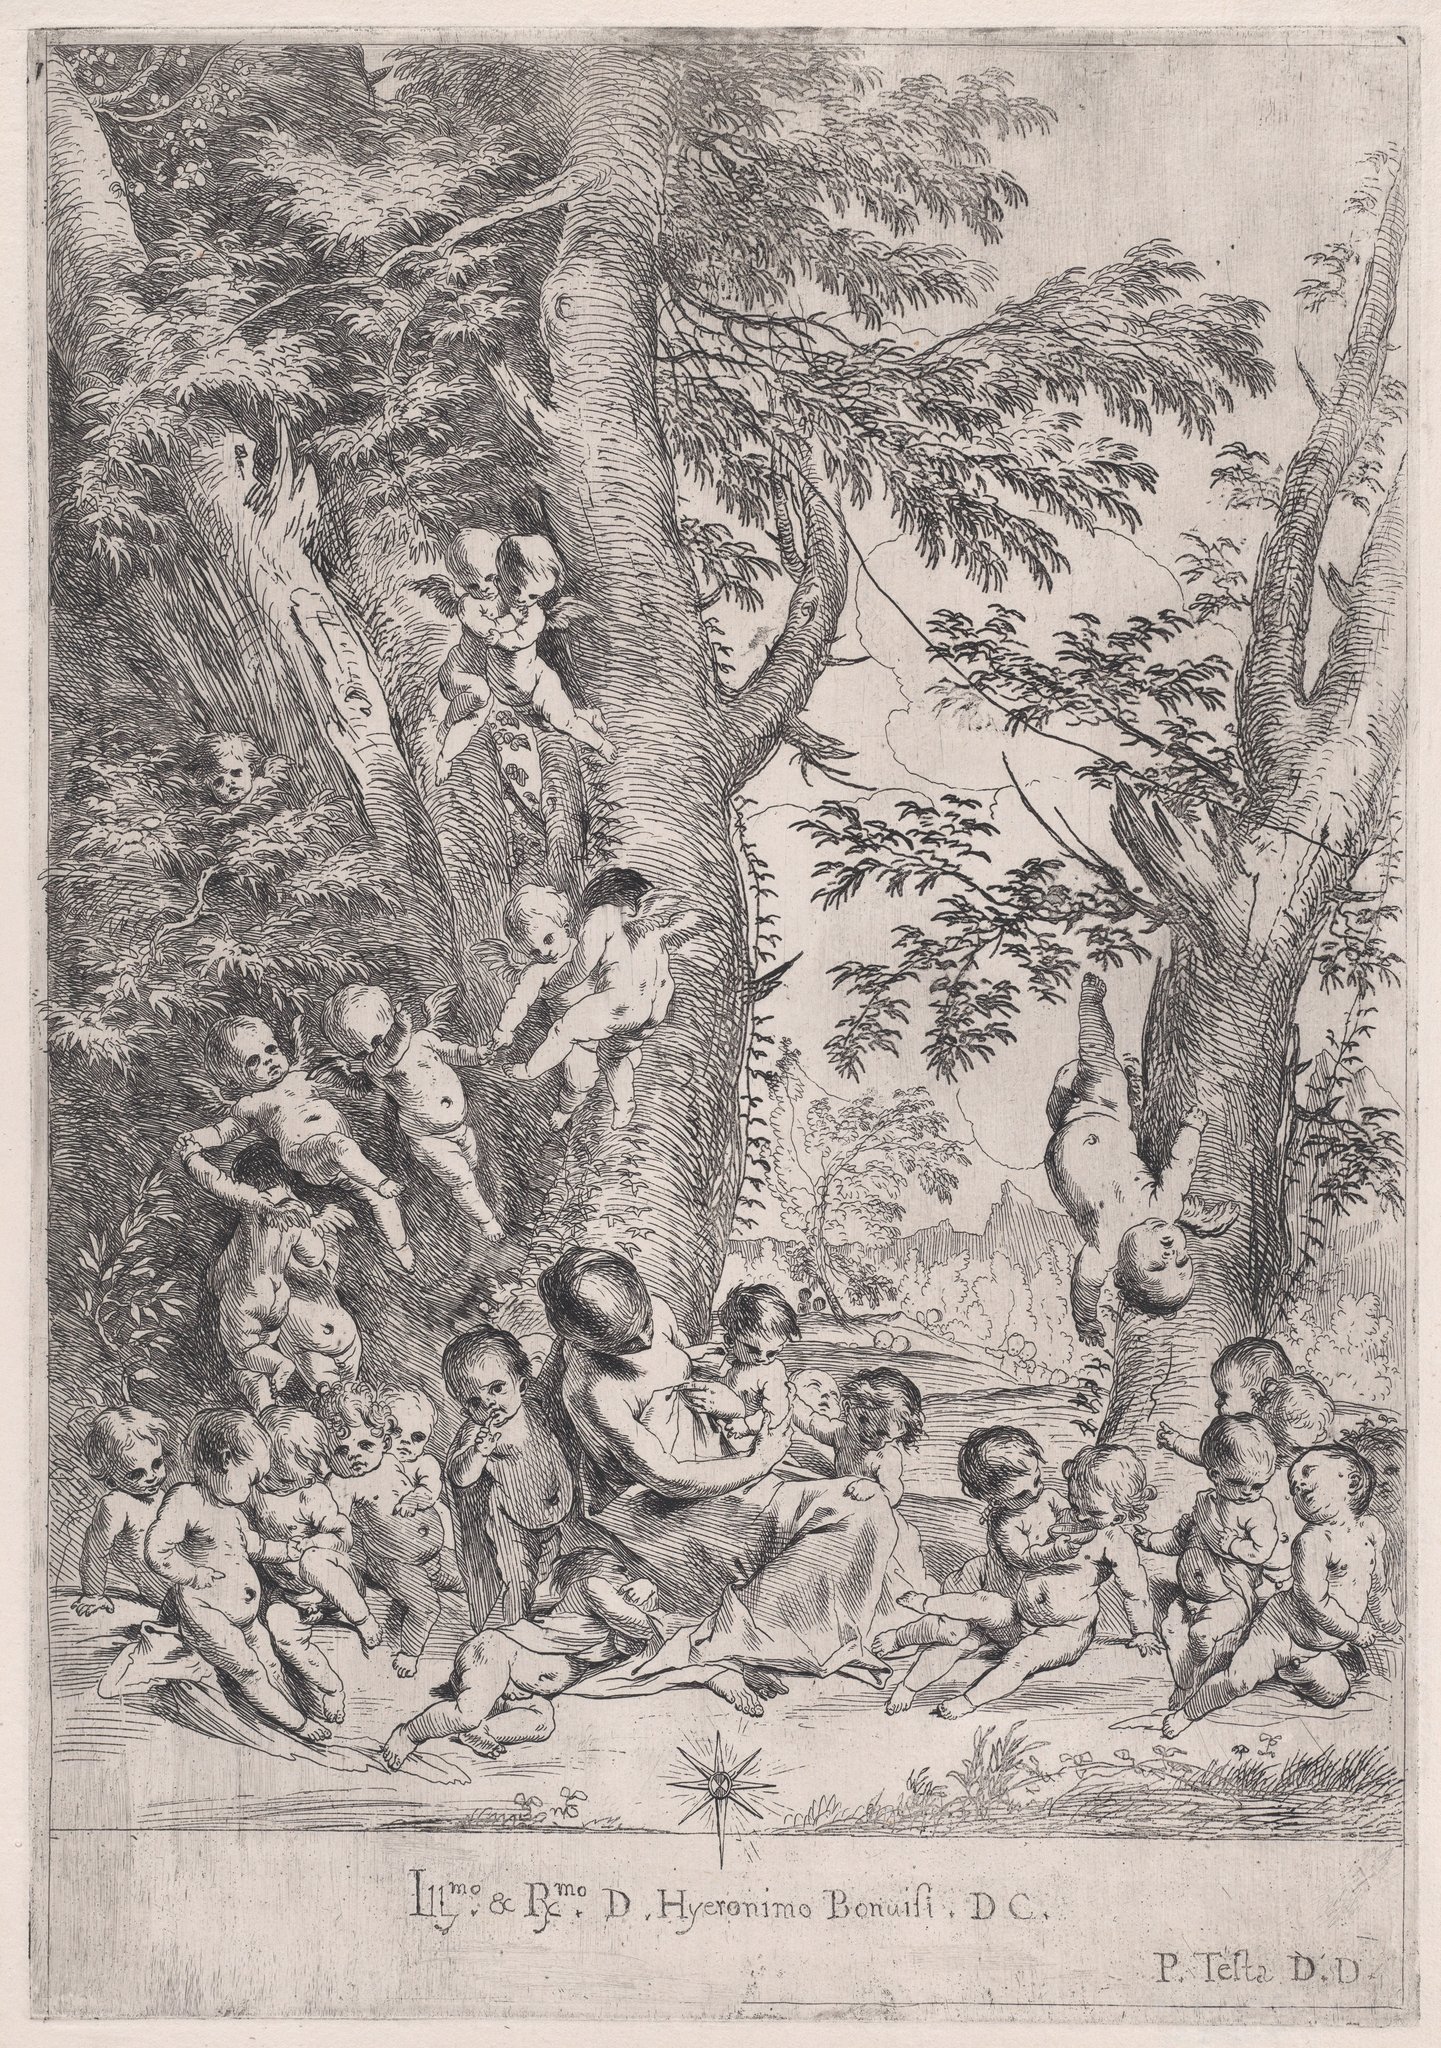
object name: print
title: The Garden of Charity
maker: pietro testa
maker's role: artist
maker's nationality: italian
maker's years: 1612-1650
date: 1631-1637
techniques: etching